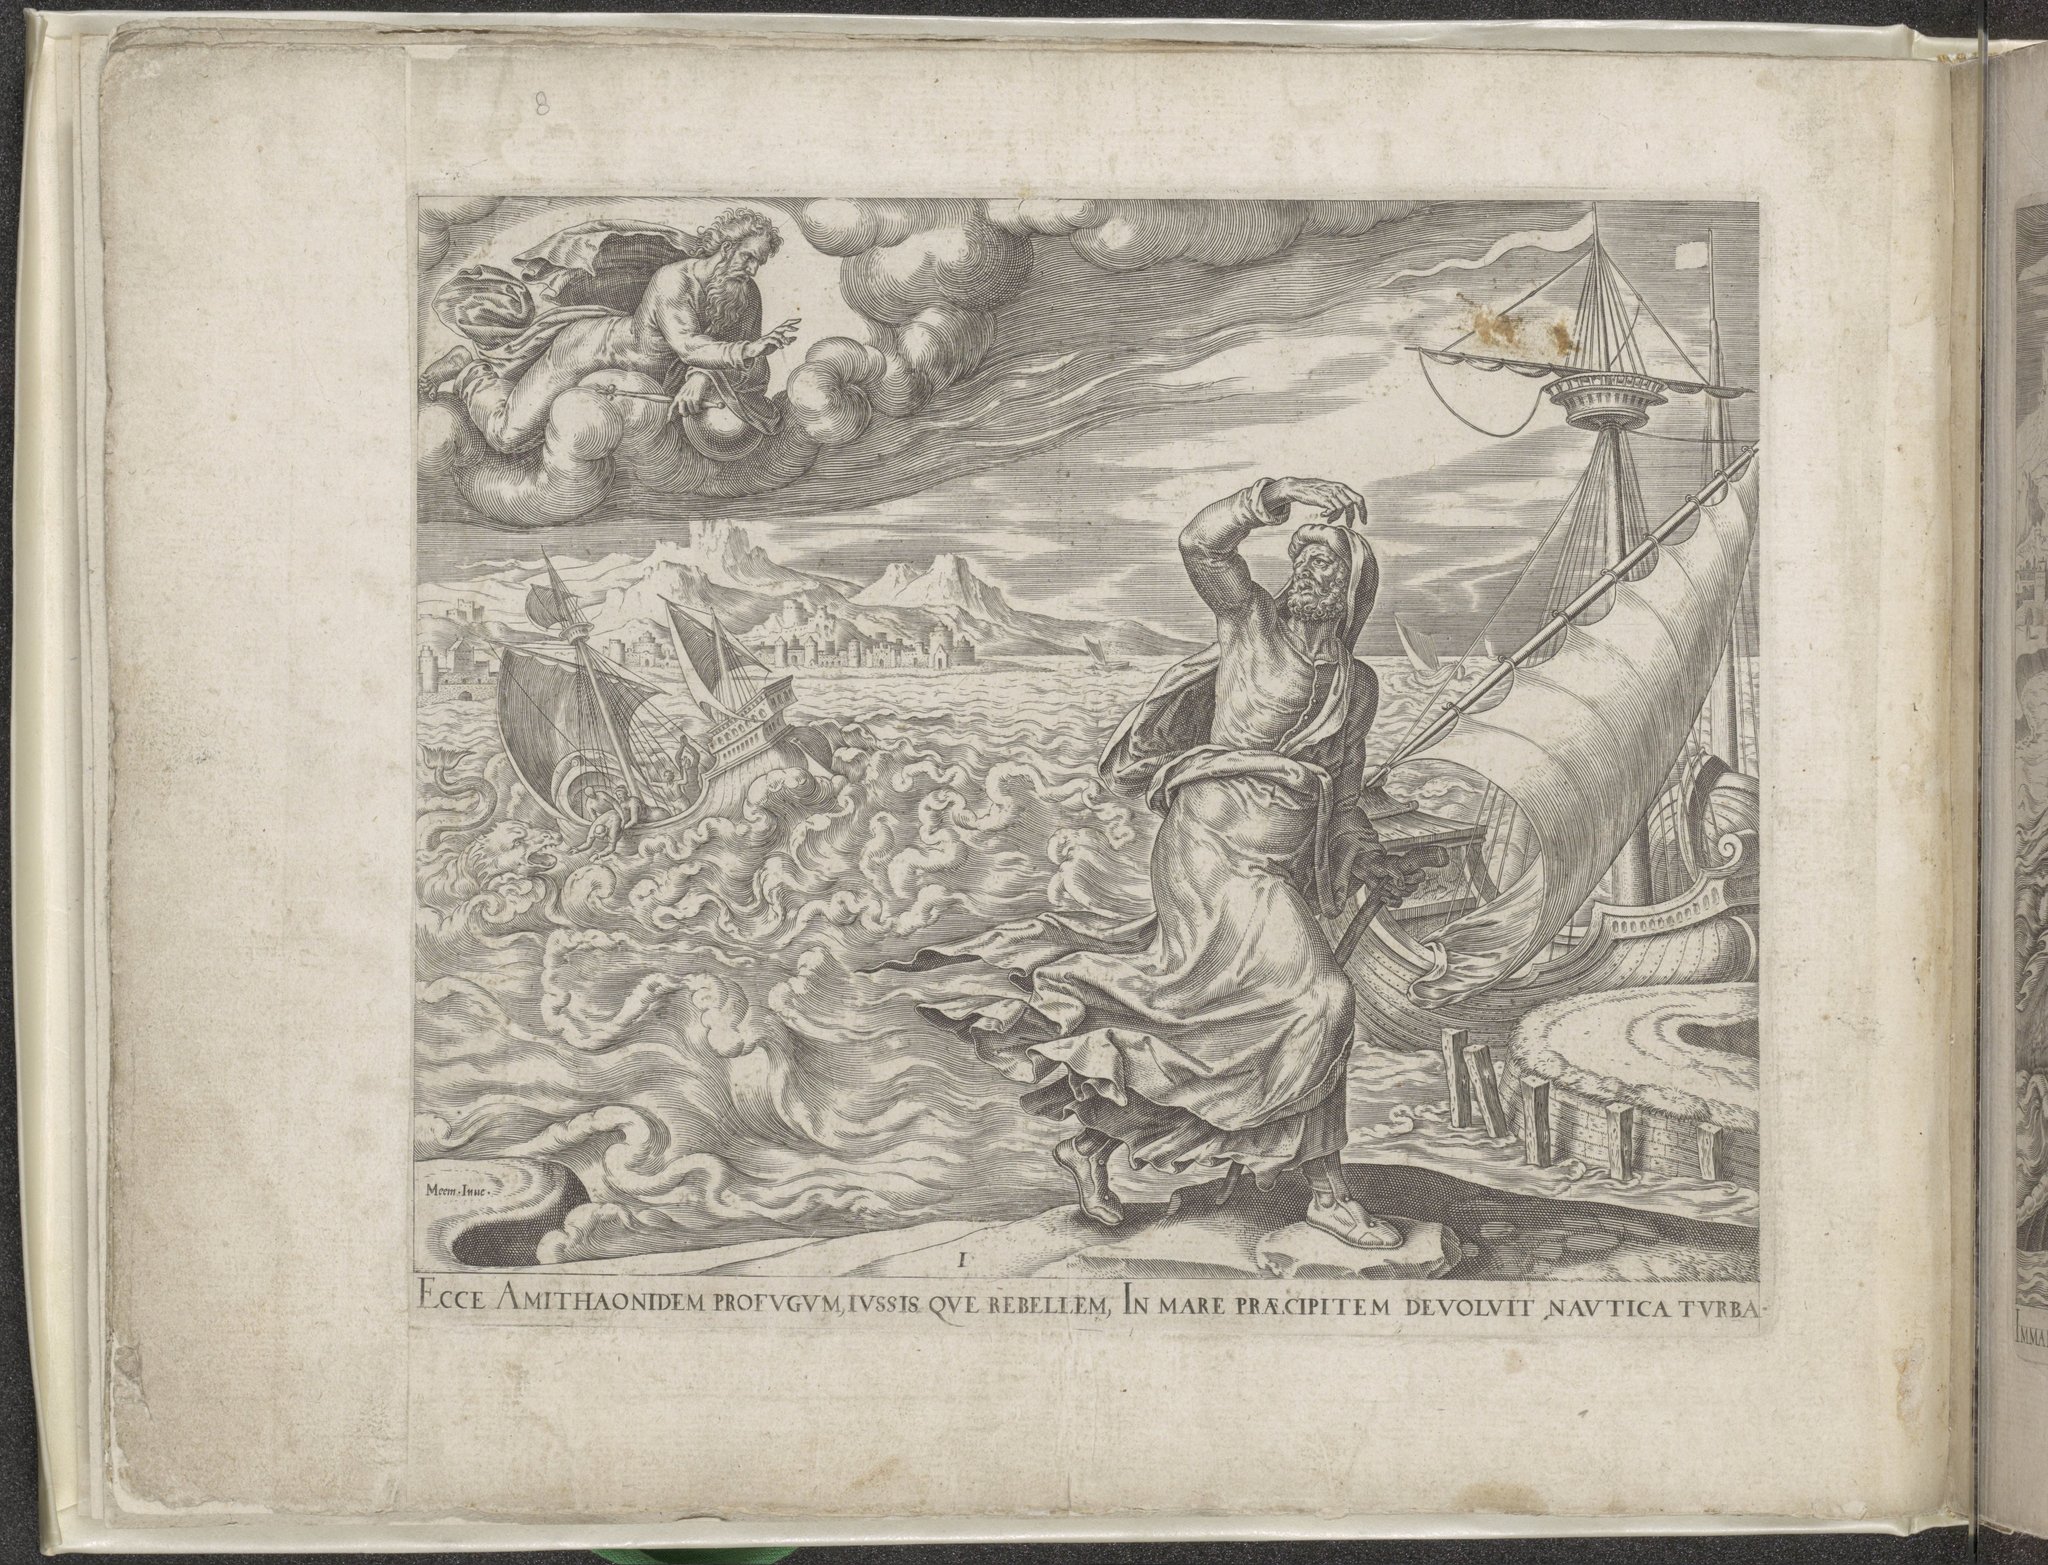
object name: print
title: Geschiedenis van Jona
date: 1566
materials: paper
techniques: engraving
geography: haarlem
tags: jonah's call and disobedience (jonah 1), jonah is sent by god to nineveh to preach to its sinful citizens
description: Jona staat aan de kustlijn en kijkt naar God die op een wolk ligt. God geeft Jona de opdracht naar Nineve te gaan. Aan de kademuur ligt het schip waarmee Jona vlucht. Op het water is te zien hoe Jona later overboord wordt gegooid en door een vis wordt opgeslokt. Onder de voorstelling een verklarende tekst in het Latijn. Deze prent maakt deel uit van een album.